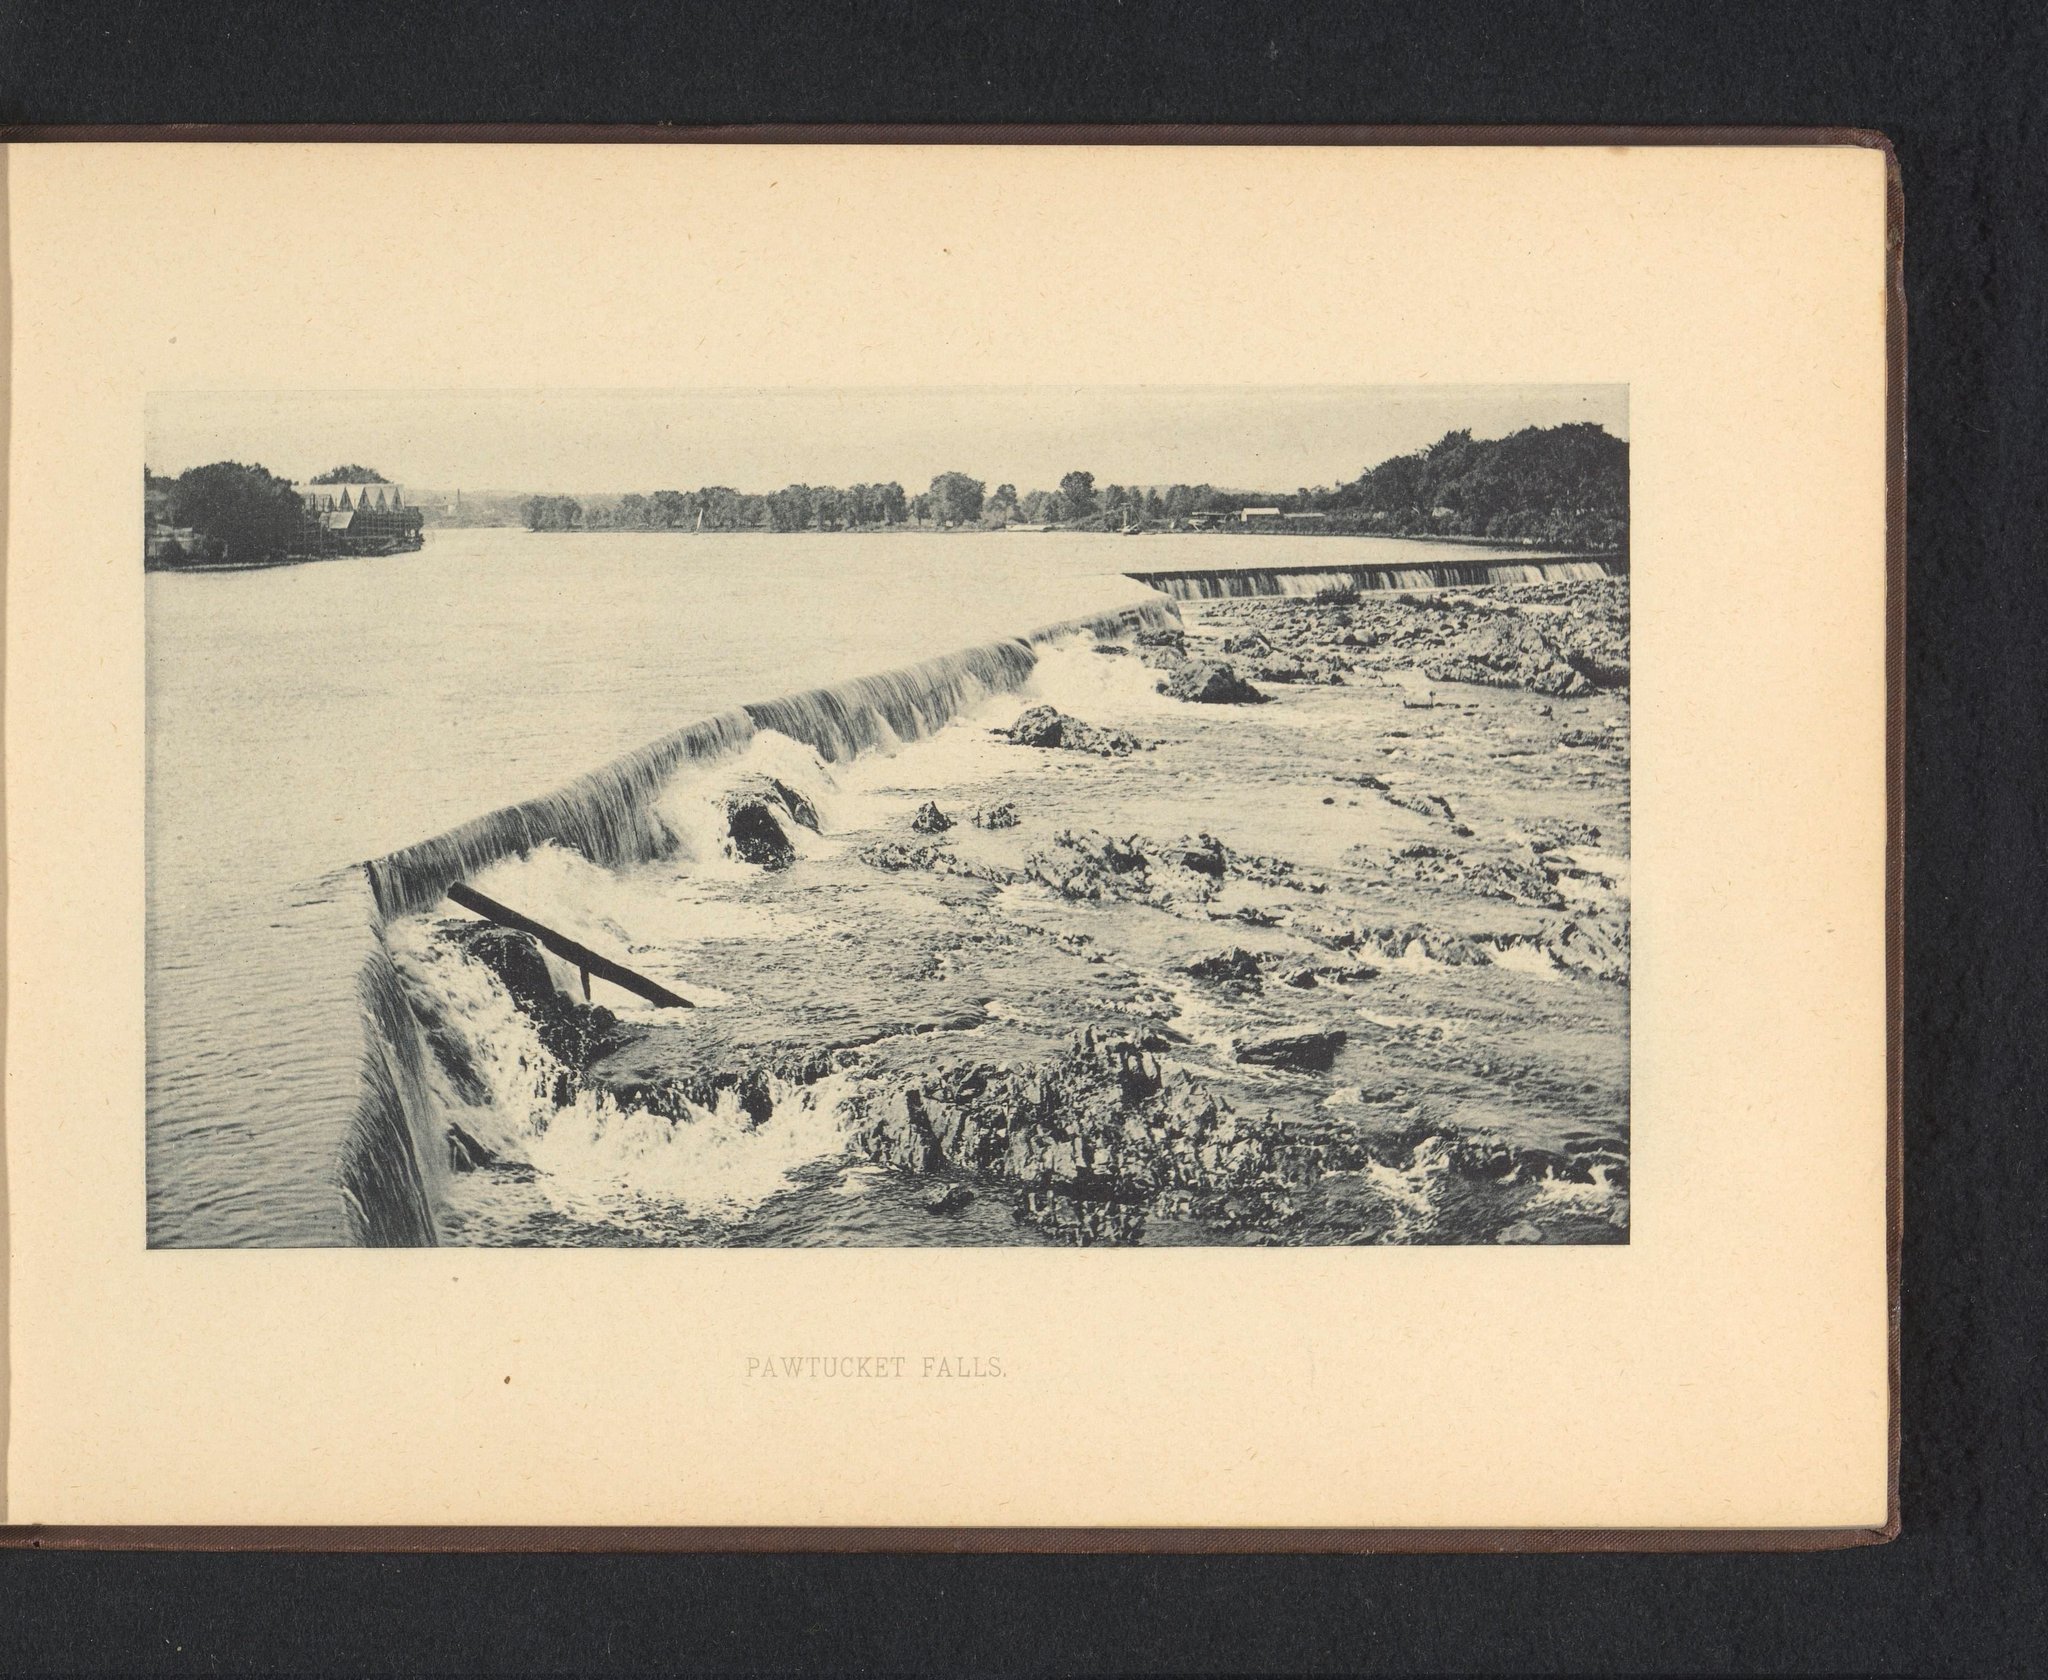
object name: page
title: Pawtucket Falls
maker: Anonymous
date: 1887-1892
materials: paper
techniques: photograph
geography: lowell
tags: river, waterfall